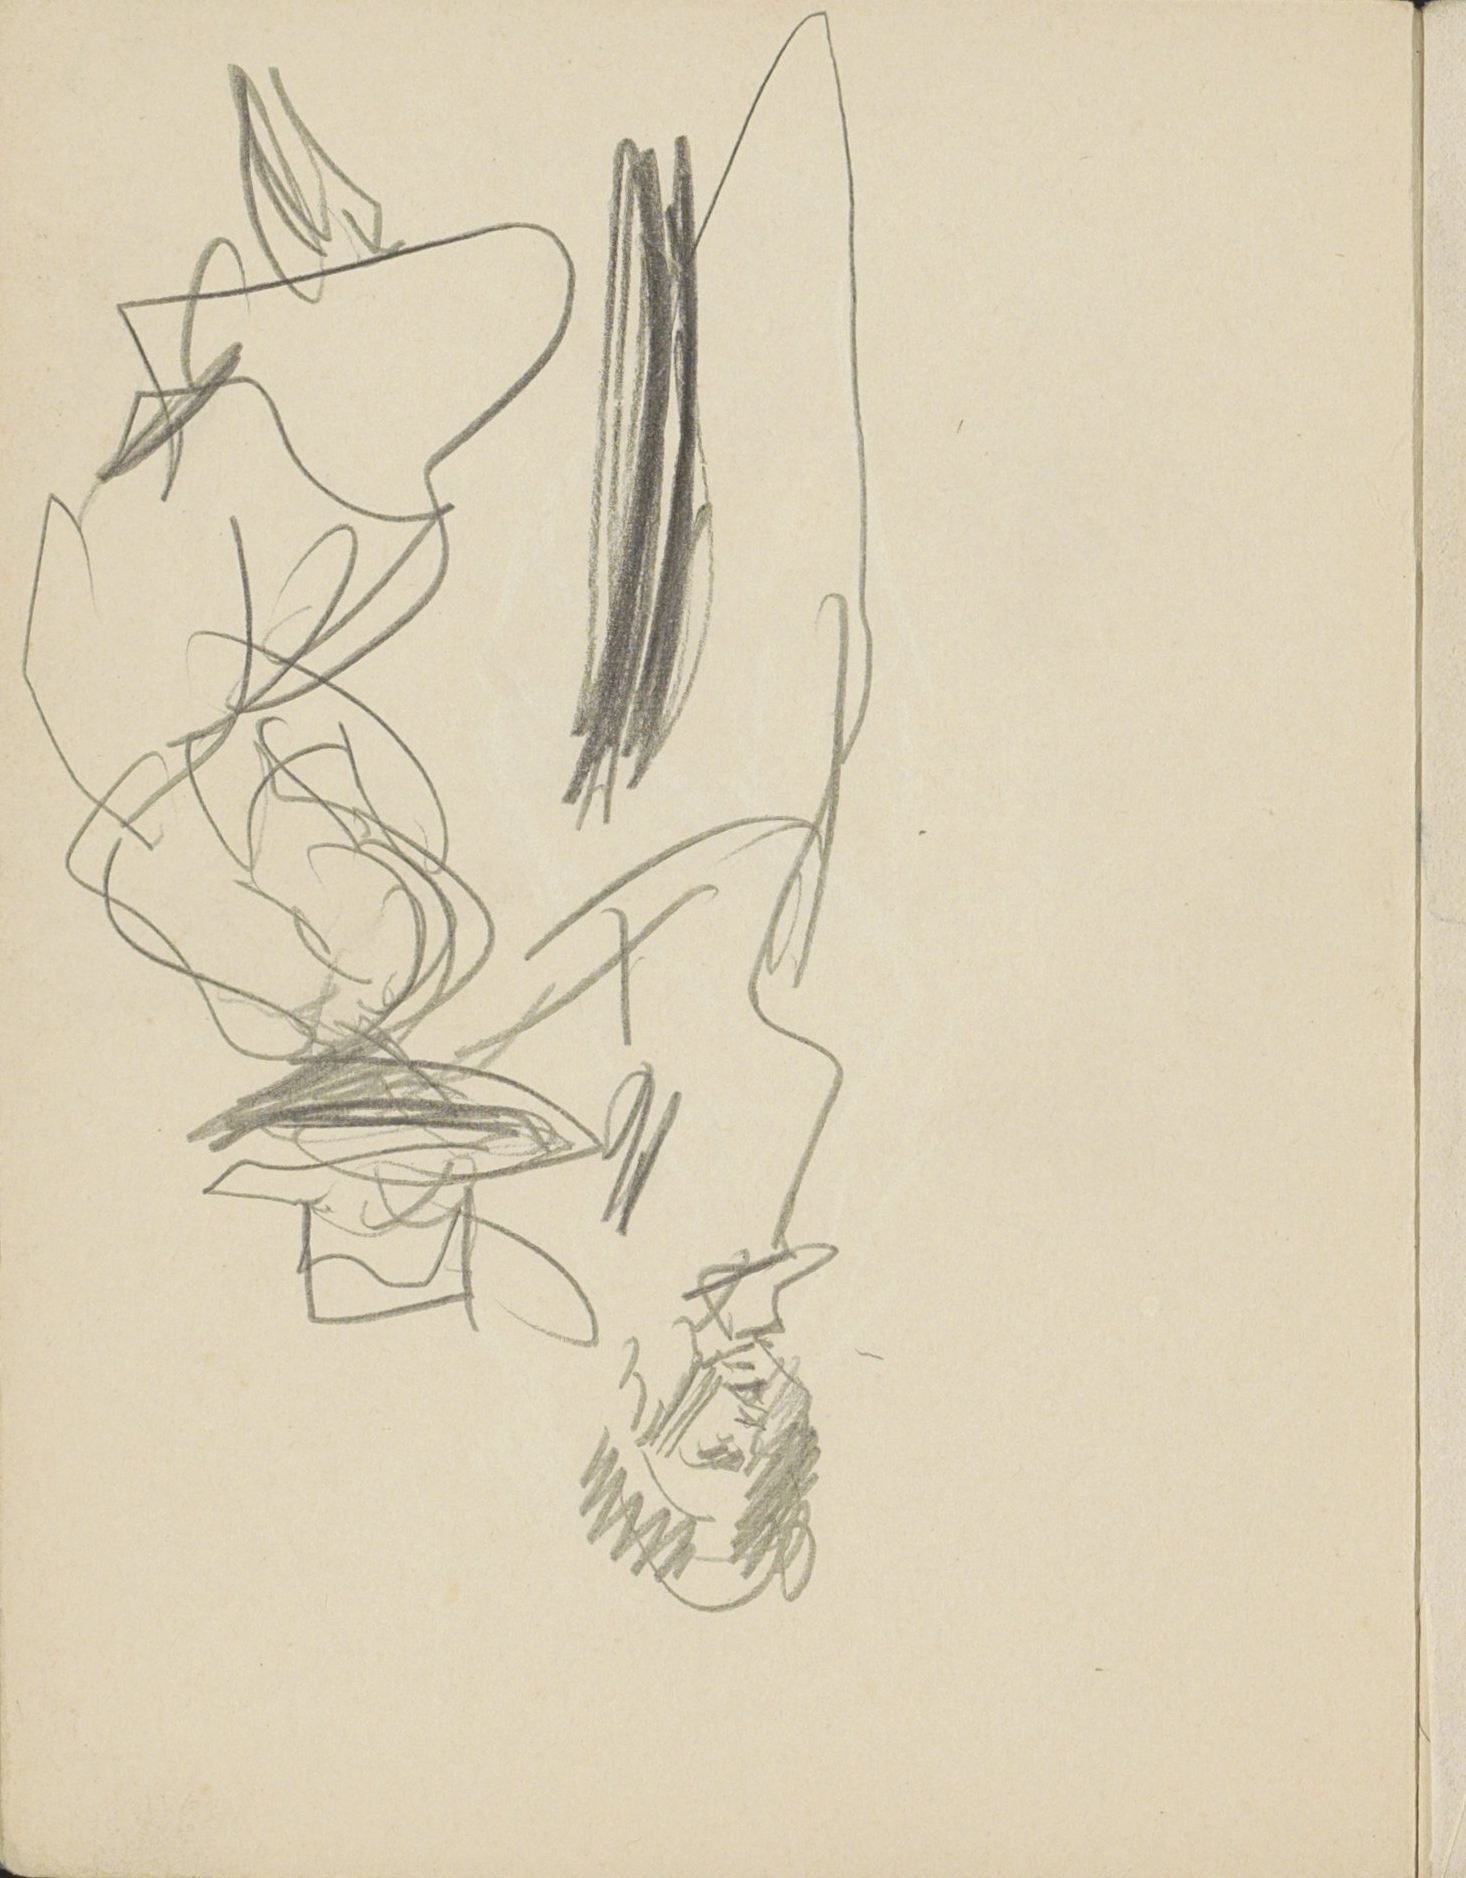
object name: sketchbook leaf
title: Staande en hurkende vrouw met hoed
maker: isaac israels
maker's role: draughtsman, painter, print maker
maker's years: 1865-1934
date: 1921-1922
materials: paper, pencil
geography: dutch east indies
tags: asiatic races and peoples, head-gear: hat (+ women's clothes), adult woman (+ standing), dutch east indies, the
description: Indische figuurstudies. Pagina 4 uit schetsboek XXXIV met 24 pagina's.